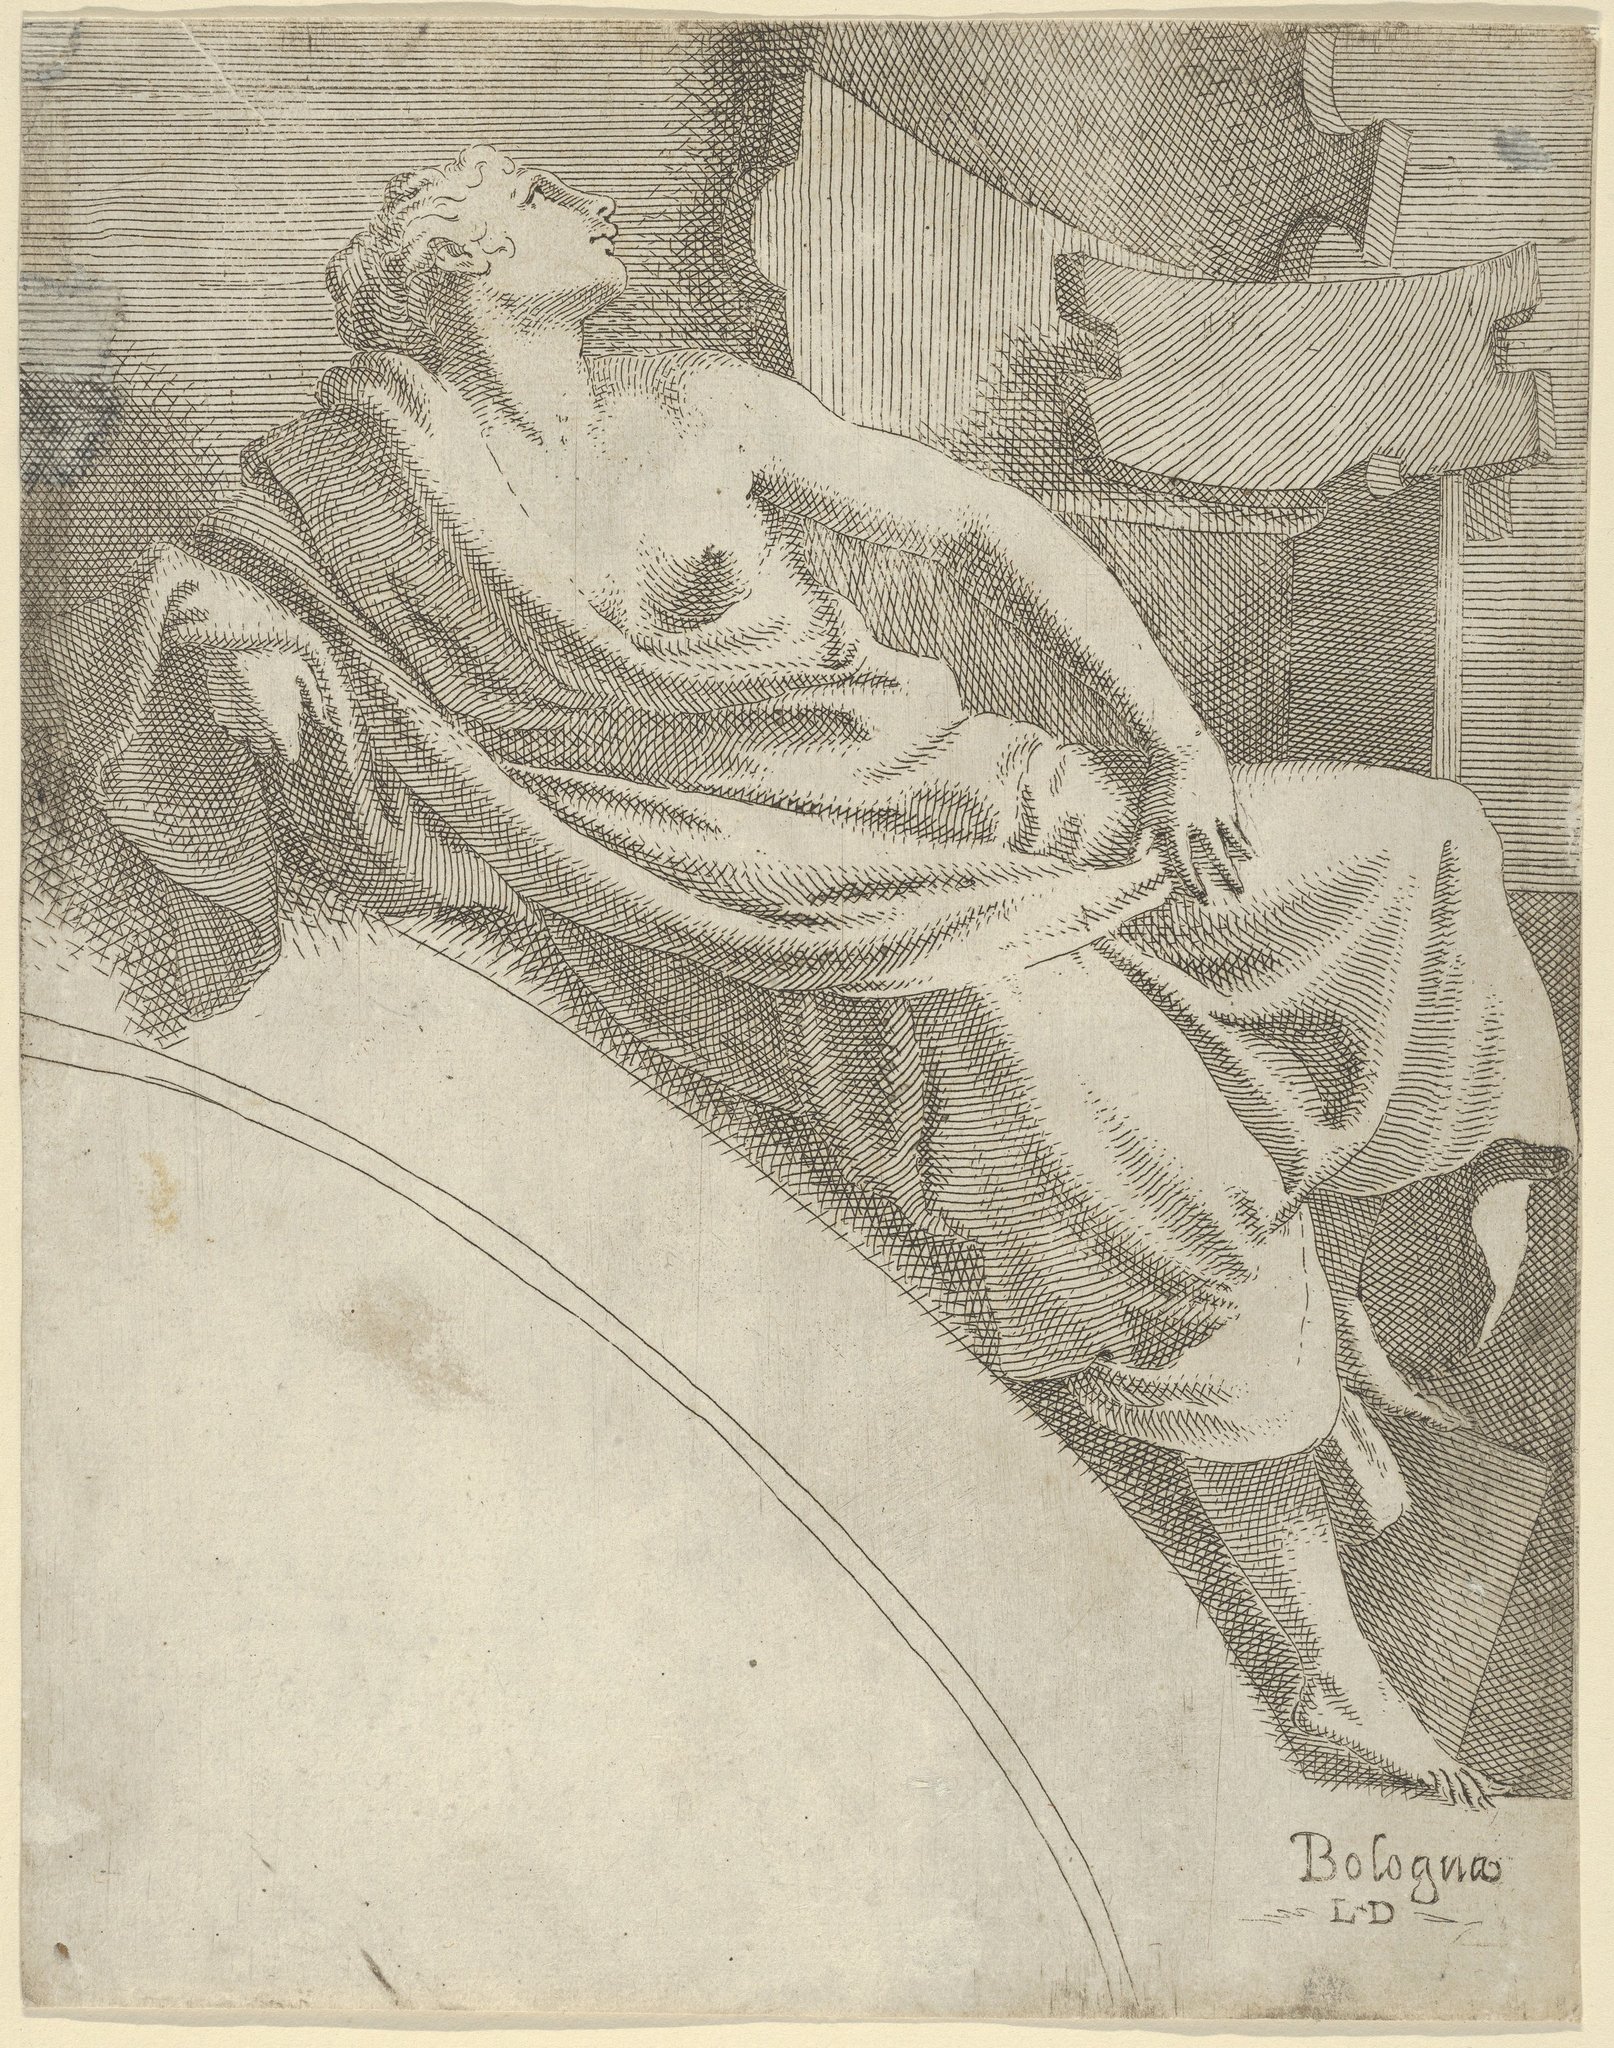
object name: print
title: Clio, from "Twelve Muses and Goddesses"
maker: léon davent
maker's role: artist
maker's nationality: french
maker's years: 1540-1556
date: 1540-1545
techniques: etching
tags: women